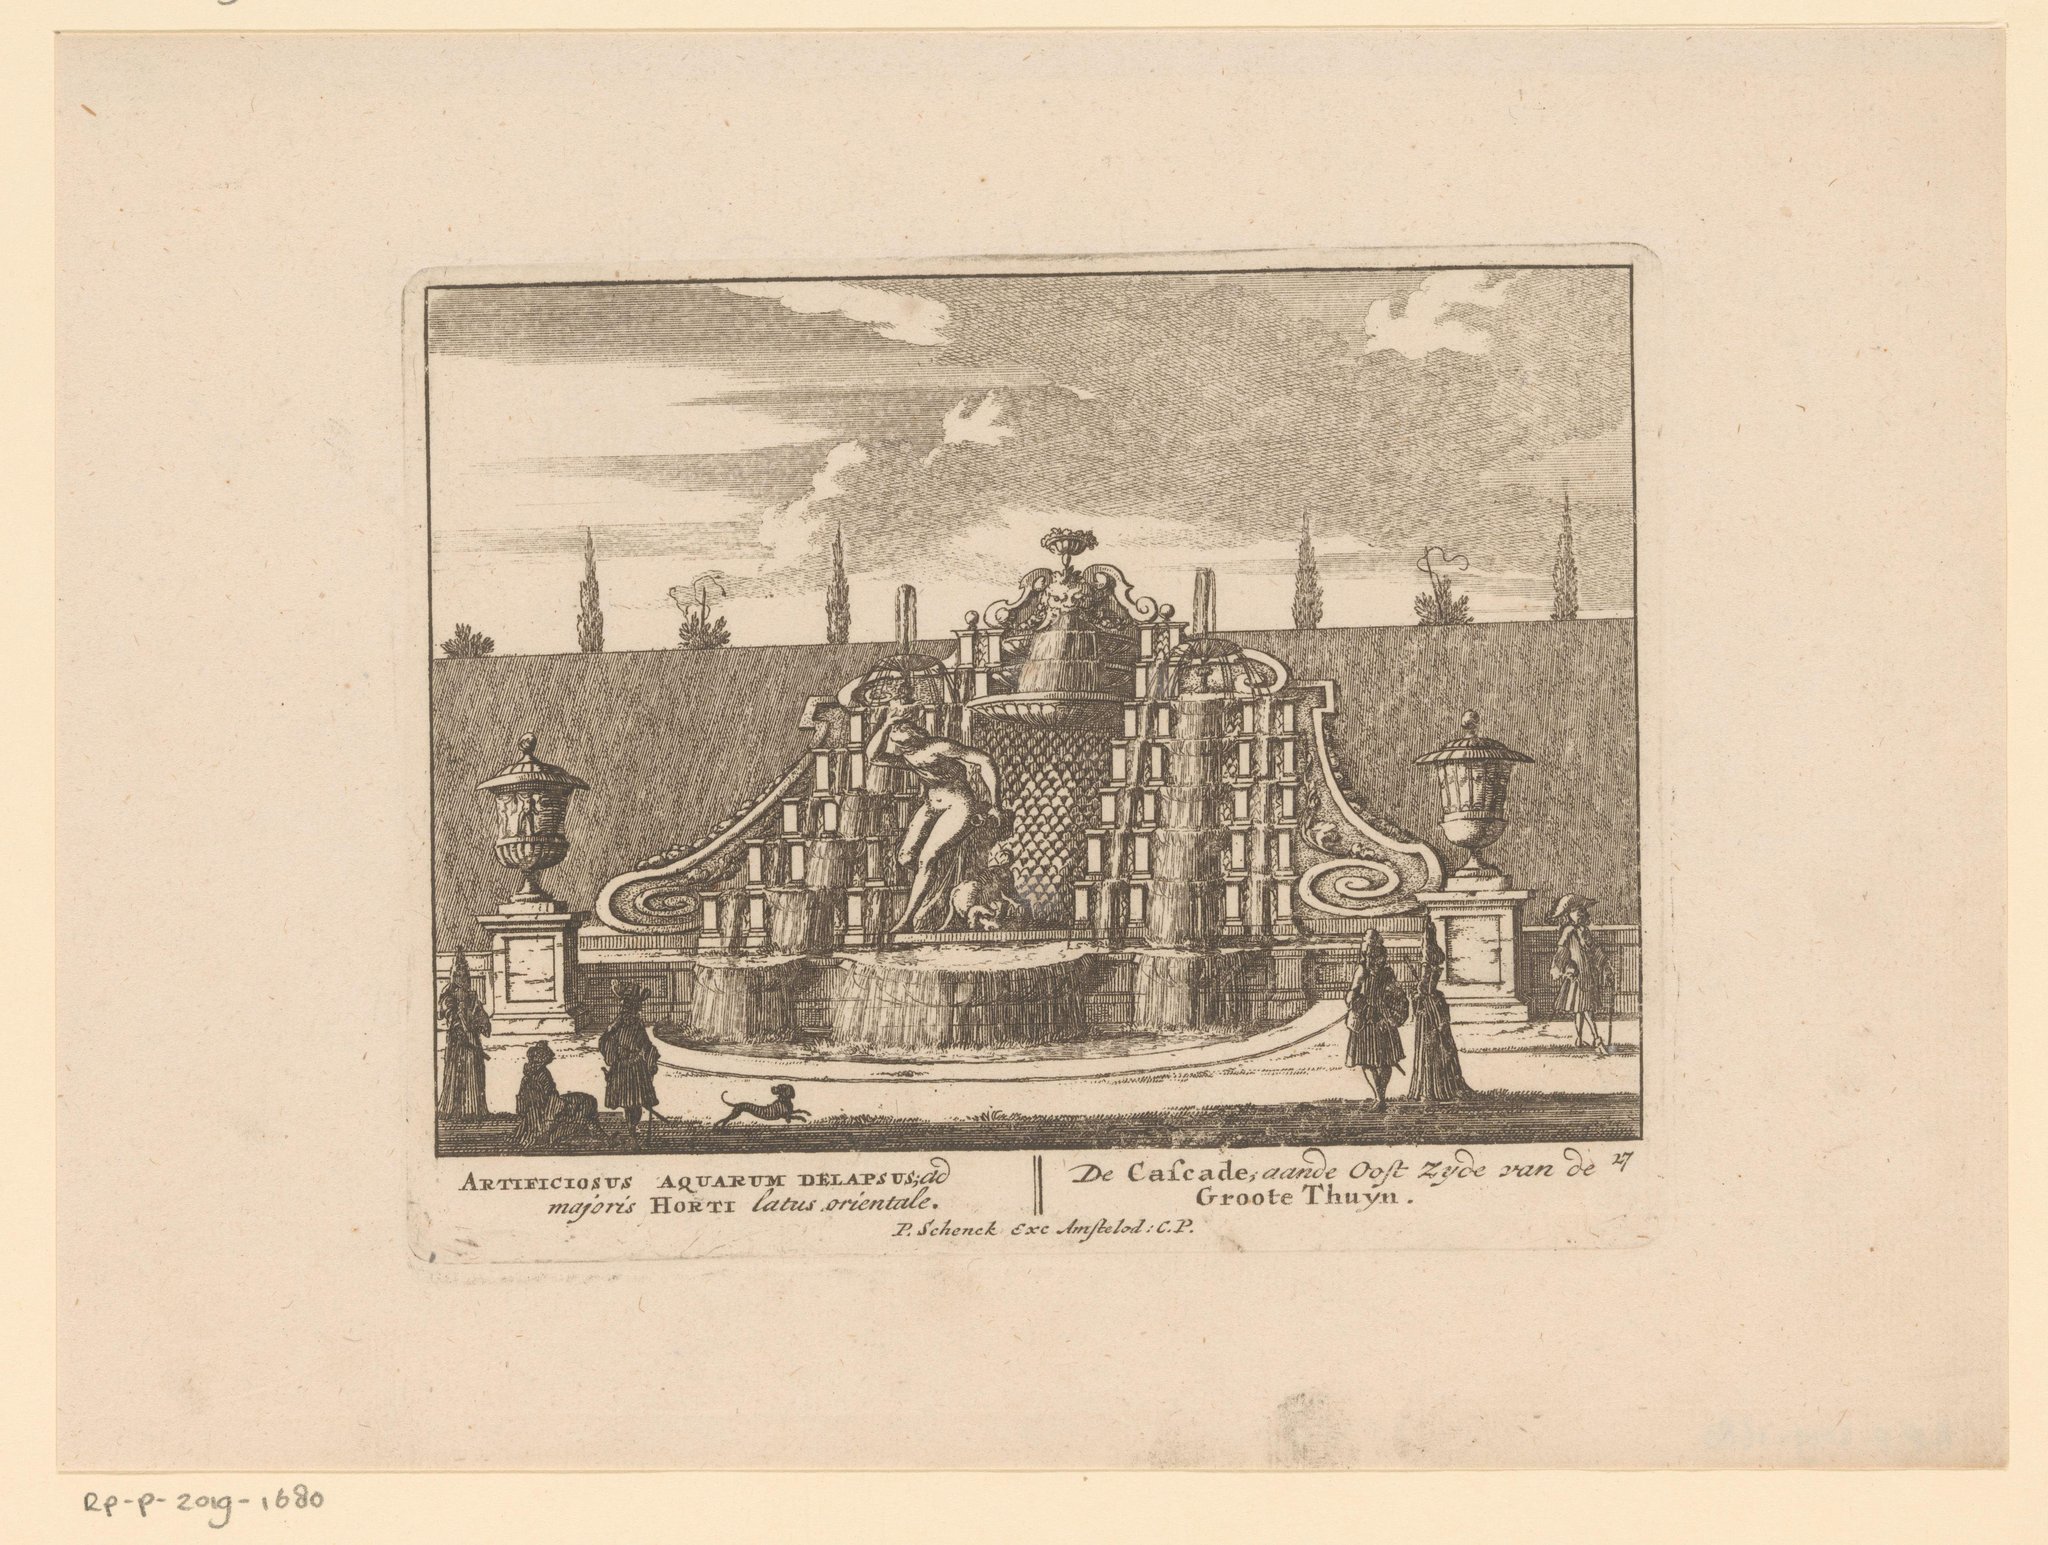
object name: print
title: Admirandorum Quadruplex Spectaculum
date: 1700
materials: paper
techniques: etching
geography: amsterdam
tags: garden, palace, garden cascade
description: Andere staat ook gebruikt in: Call, Jan van. Admirandorum Quadruplex Spectaculum. Amsterdam: Pieter Schenk (I), [1700].* * De titelprent, opdracht en het portret van Frederik van Saksen zijn gegraveerd door Pieter Schenk (I). De overige prenten uit deze serie zijn, zoals aangegeven op de titelprent, van de hand van Jan van Call (I).